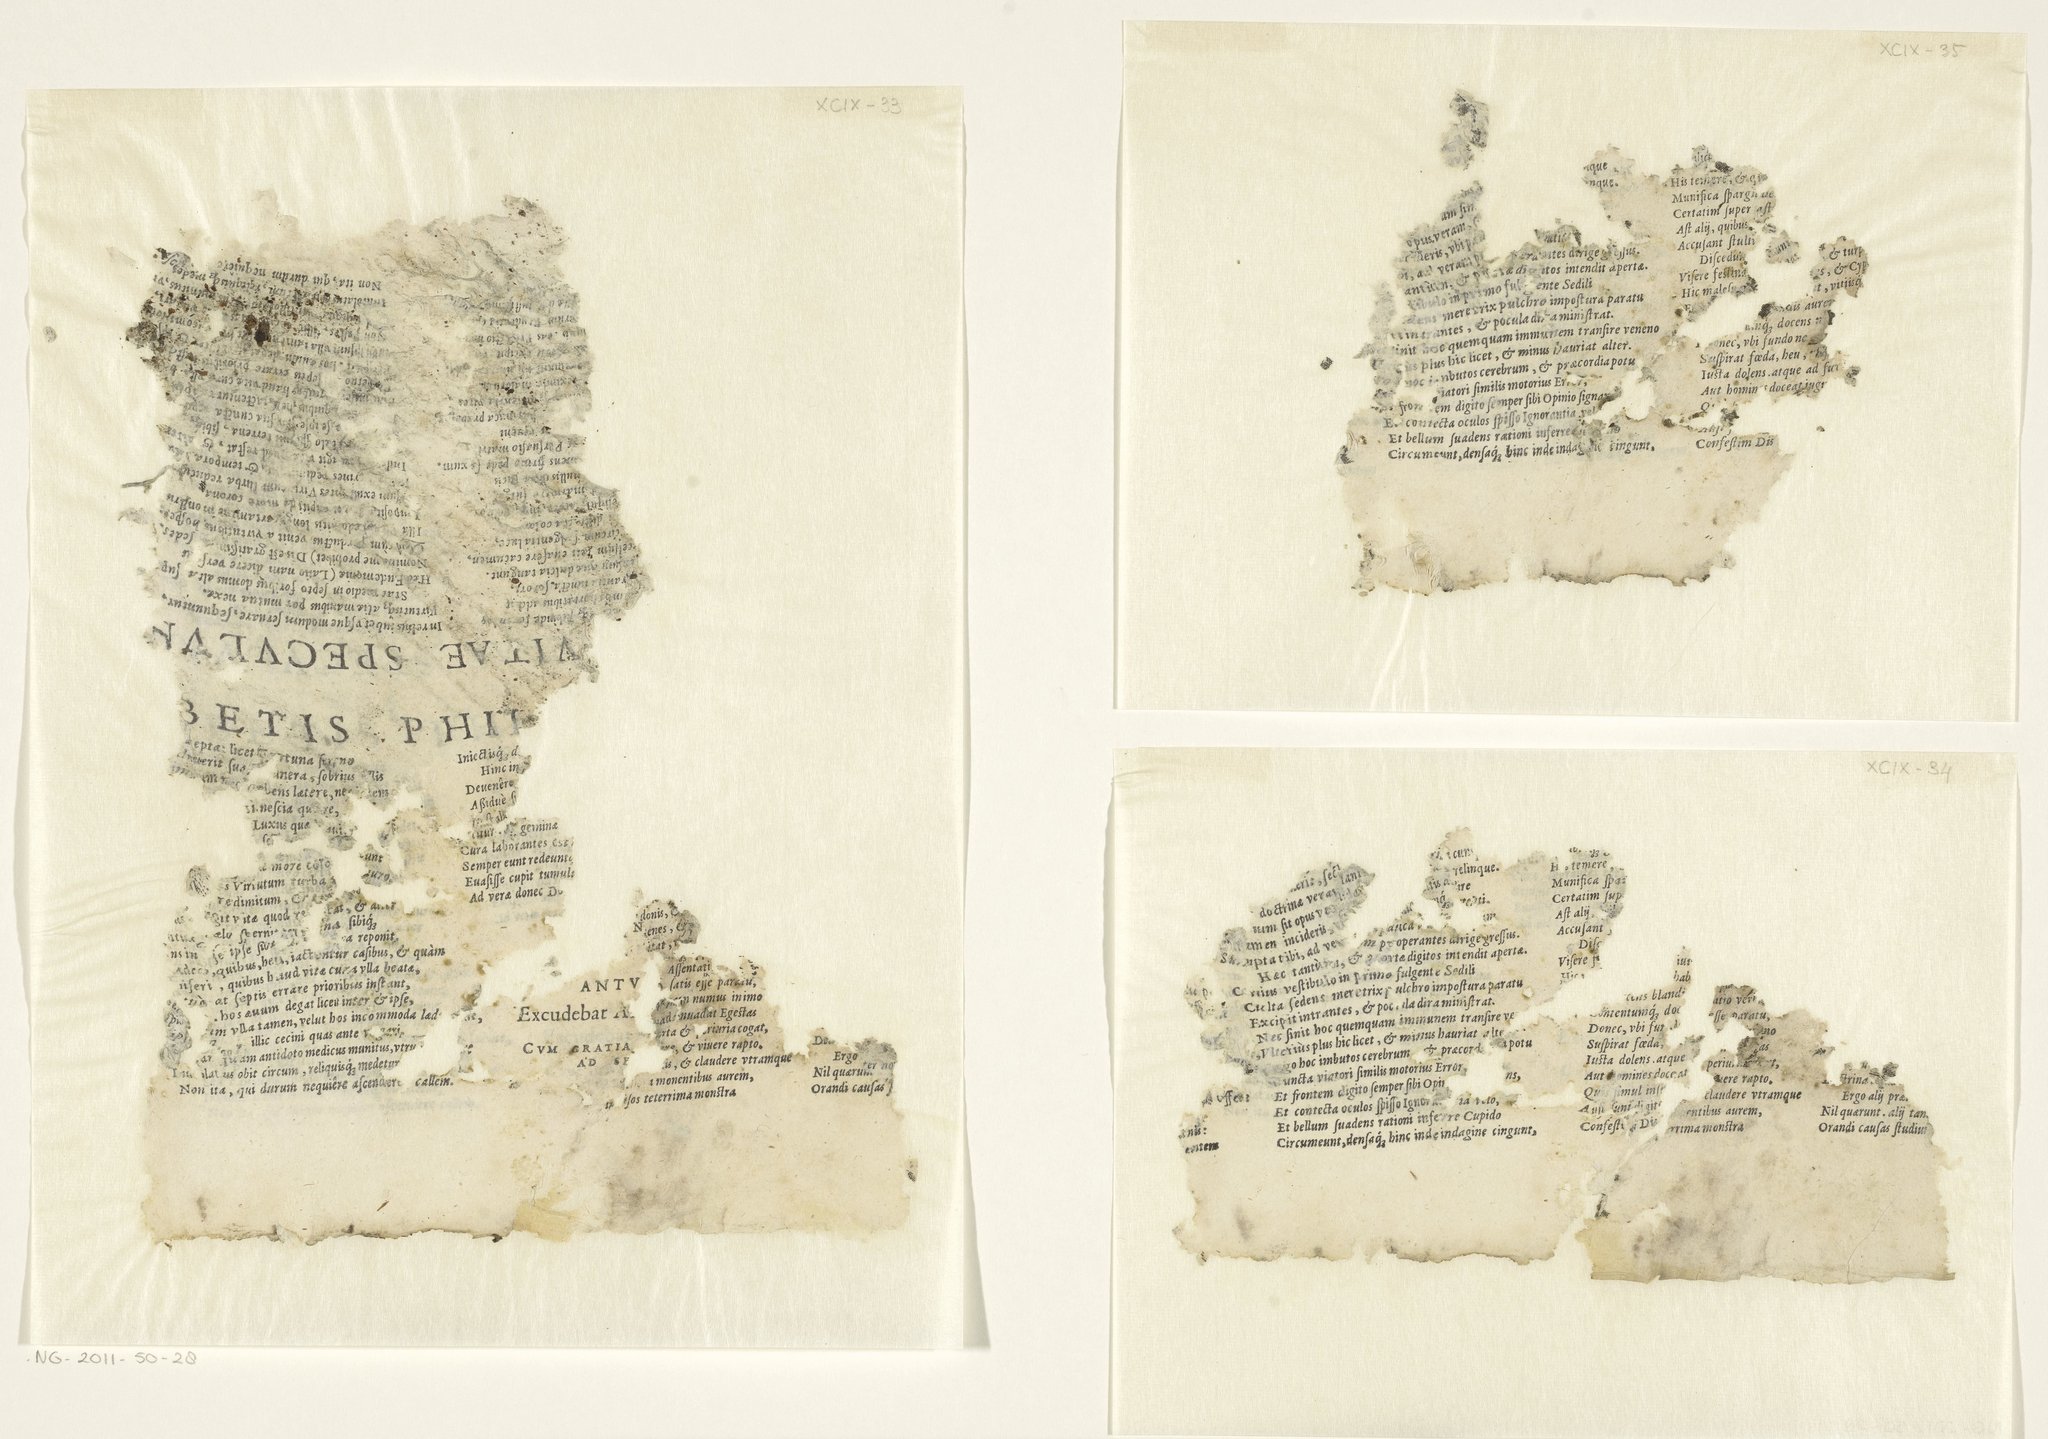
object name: print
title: Tabula Cebetis Carta Vitae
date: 1561-1596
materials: paper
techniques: letterpress printing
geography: antwerp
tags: 'tabula cebetis'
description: Het tekstblad bestond origineel uit twee bladen. De prenten in de Nova Zembla collectie zijn tijdens een expeditie van Willem Barendsz en Jacob van Heemskerk in 1596-1597 noodgedwongen in het winterkamp, het ‘Behouden Huis’, op het eiland achtergelaten. De prenten waren in één of meerdere stapels als handelswaar meegenomen vanuit Amsterdam. Bijna drie eeuwen later, in 1871, keerde de Noor Elling Carlsen terug naar Nova Zembla en vond daar de restanten van het ‘Behouden Huis, inclusief een groot deel van de inventaris. Een deel van de prenten, in de vorm van aaneengekoekte kluiten, werd toen ook teruggevonden. De papierkluiten waren soms op meerdere plekken gebroken. Tussen 1975-1979 zijn de prenten van elkaar gescheiden. Dit leverde in totaal ca. 1000 fragmenten van ca. 400 afdrukken van ca. 150 verschillende prenten op. Voor zover mogelijk zijn de fragmenten samengevoegd en zijn de prenten gereconstrueerd.